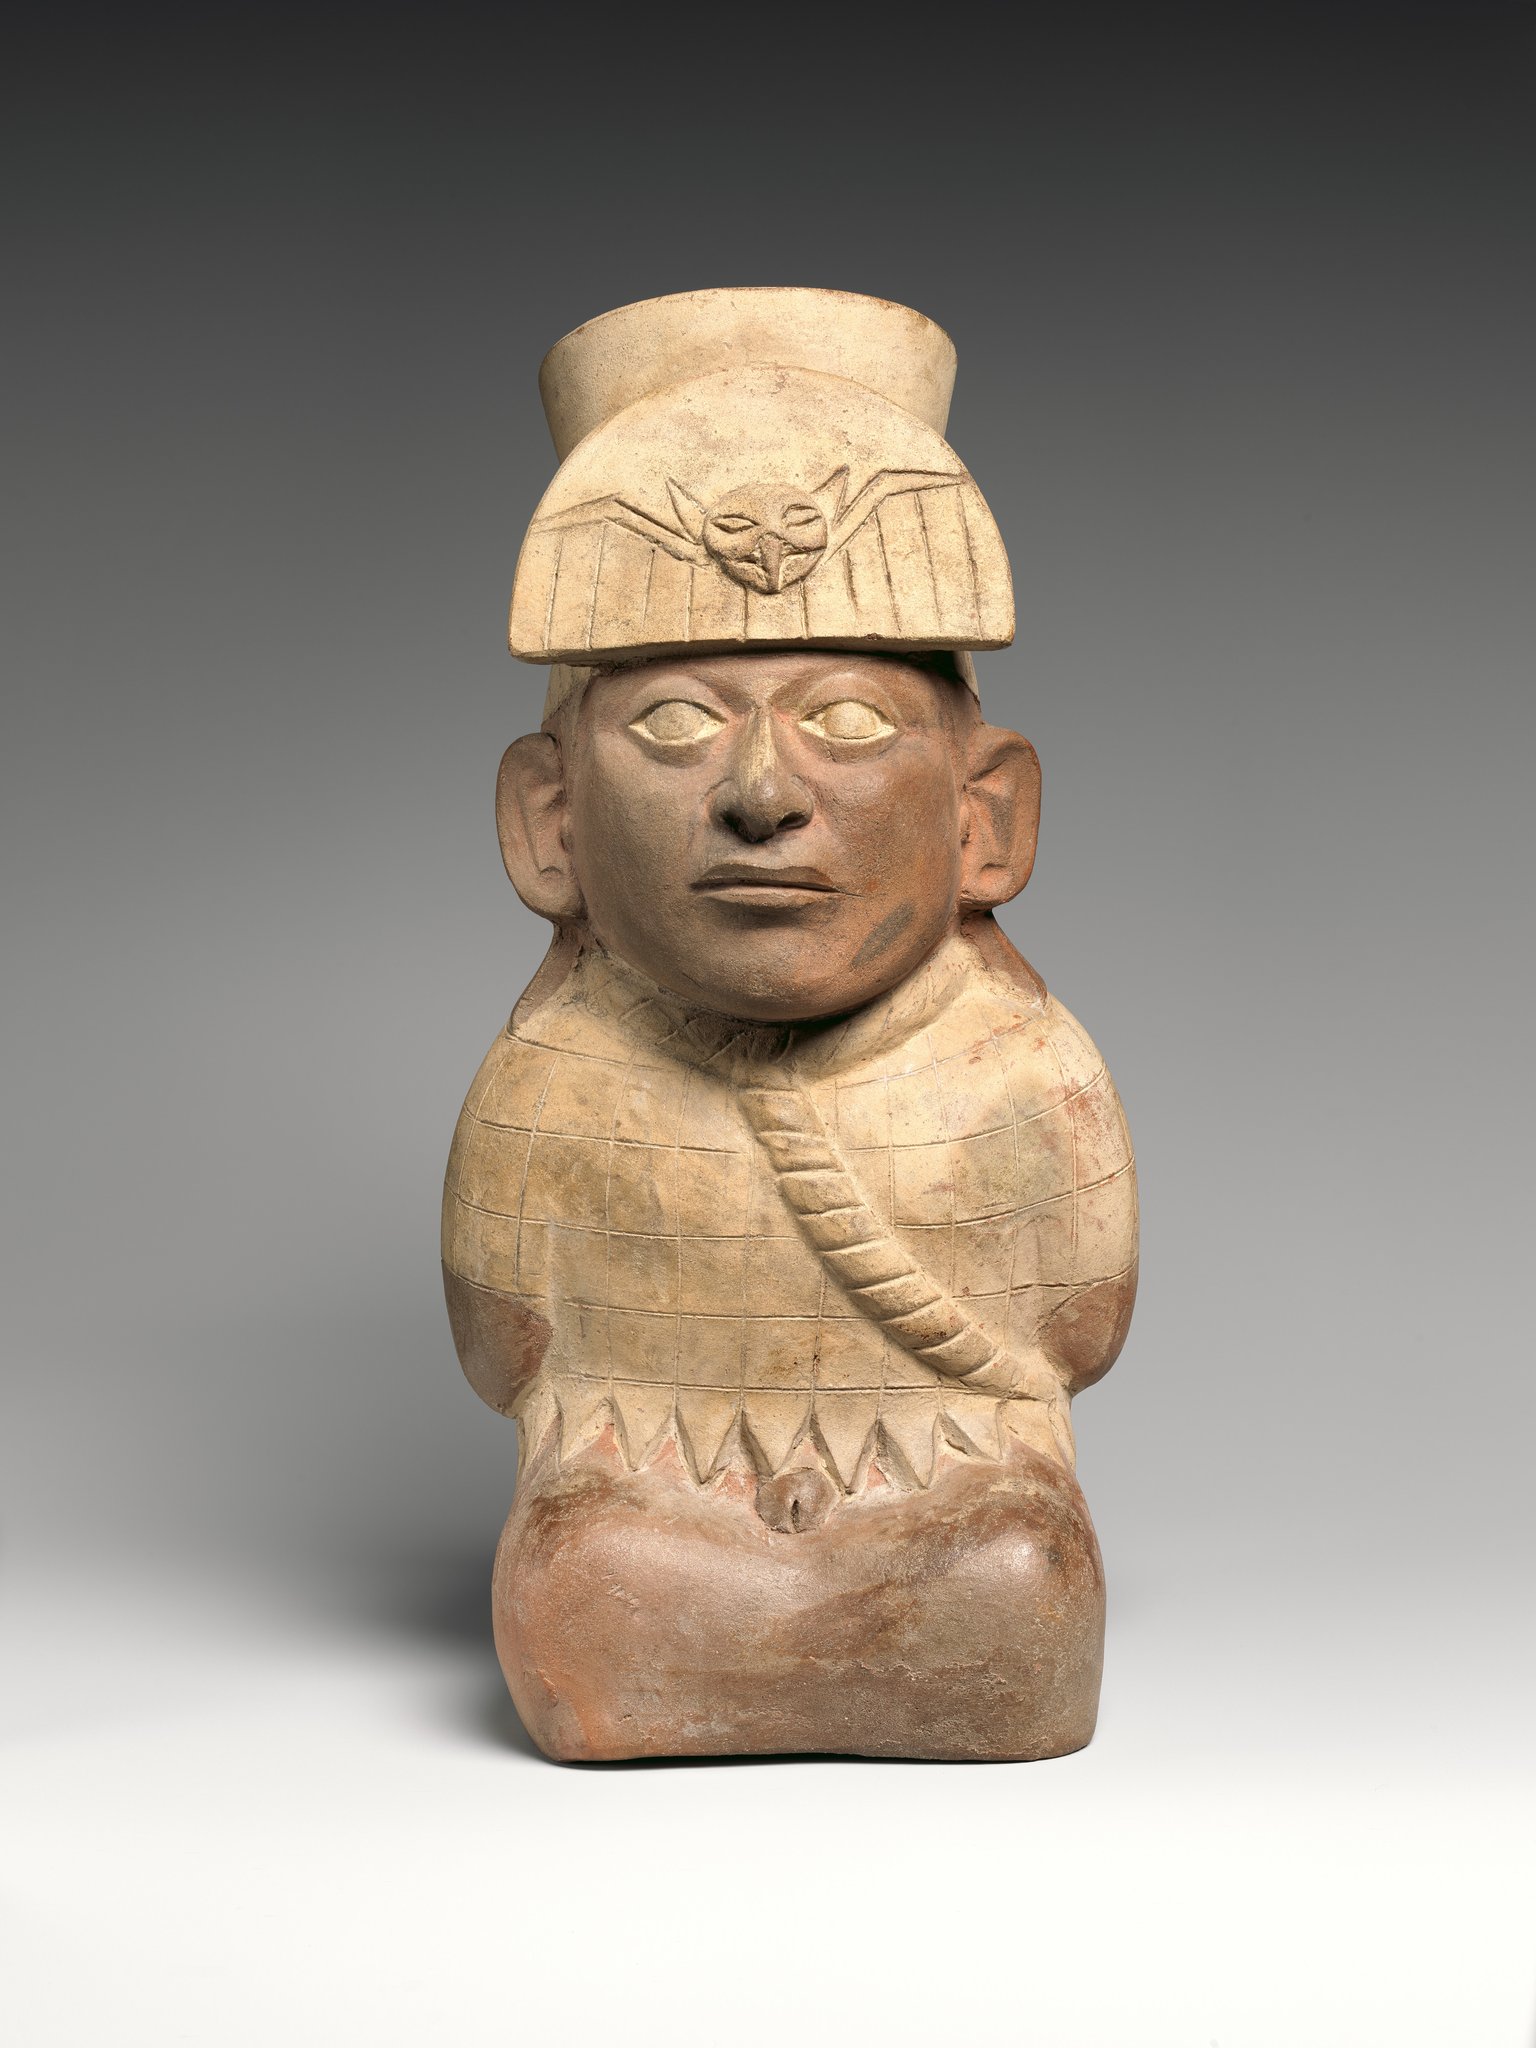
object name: jar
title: Prisoner jar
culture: moche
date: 200-800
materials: ceramic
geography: peru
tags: prisoners,men